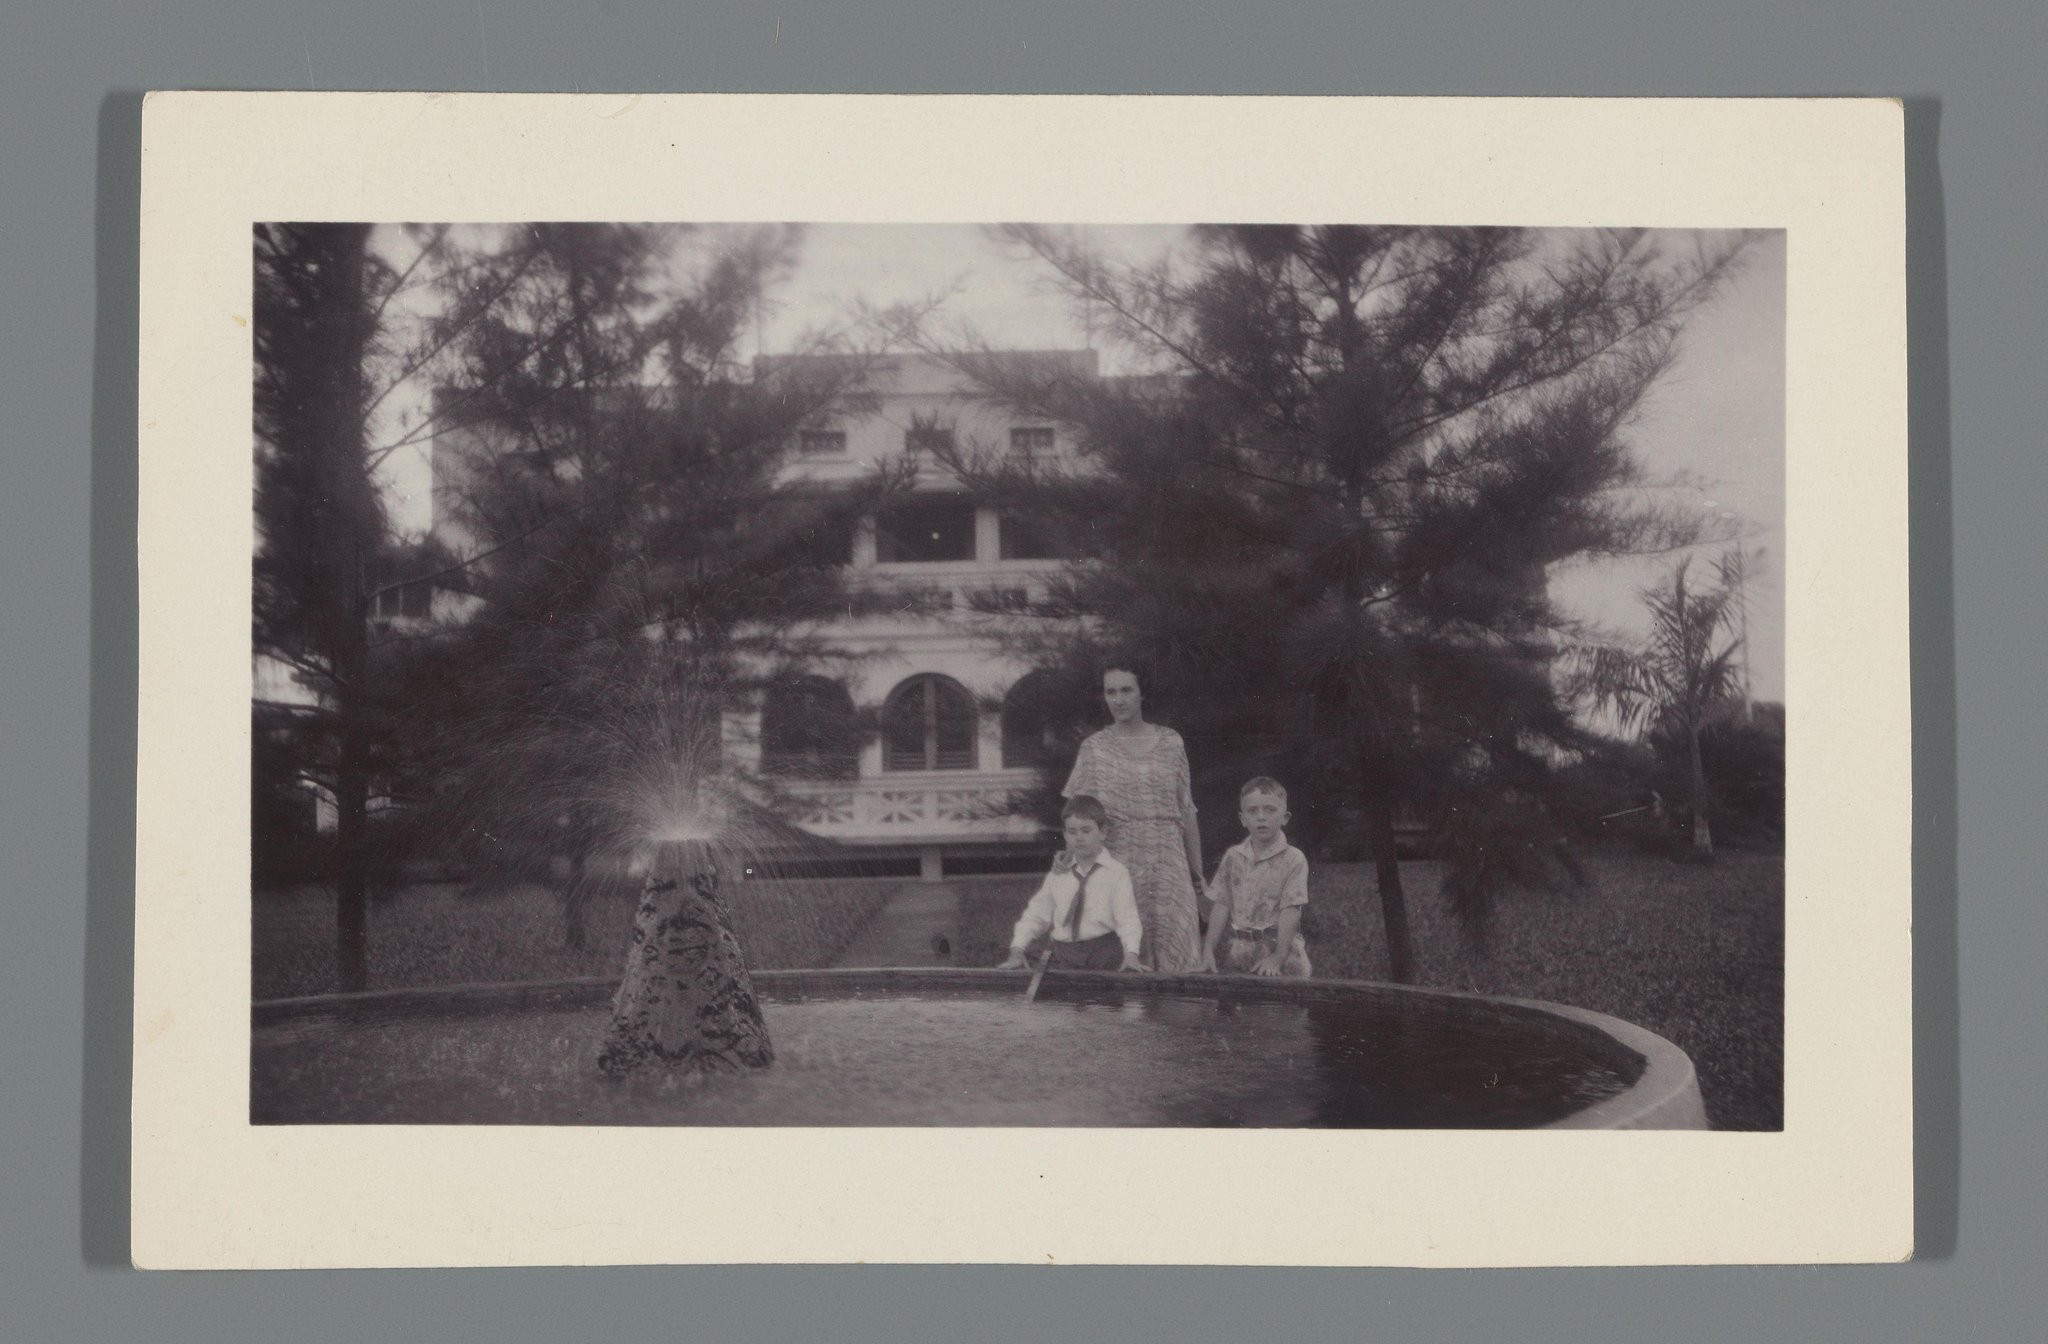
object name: photograph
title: Mary Elsbach met kinderen te Moengo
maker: Anonymous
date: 1925-1927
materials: photographic support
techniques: photography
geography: suriname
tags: jetten, familie, moengo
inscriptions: inscription: ‘Moengo Mary Elsbach en Peter op bezoek’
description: Mary Elsbach met twee jongetjes bij een fontein voor een huis te Moengo, op bezoek bij de familie Jetten. Onderdeel van het ensemble met foto's van de familie van ingenieur Jetten in de mijnbouwstad Moengo in Suriname.